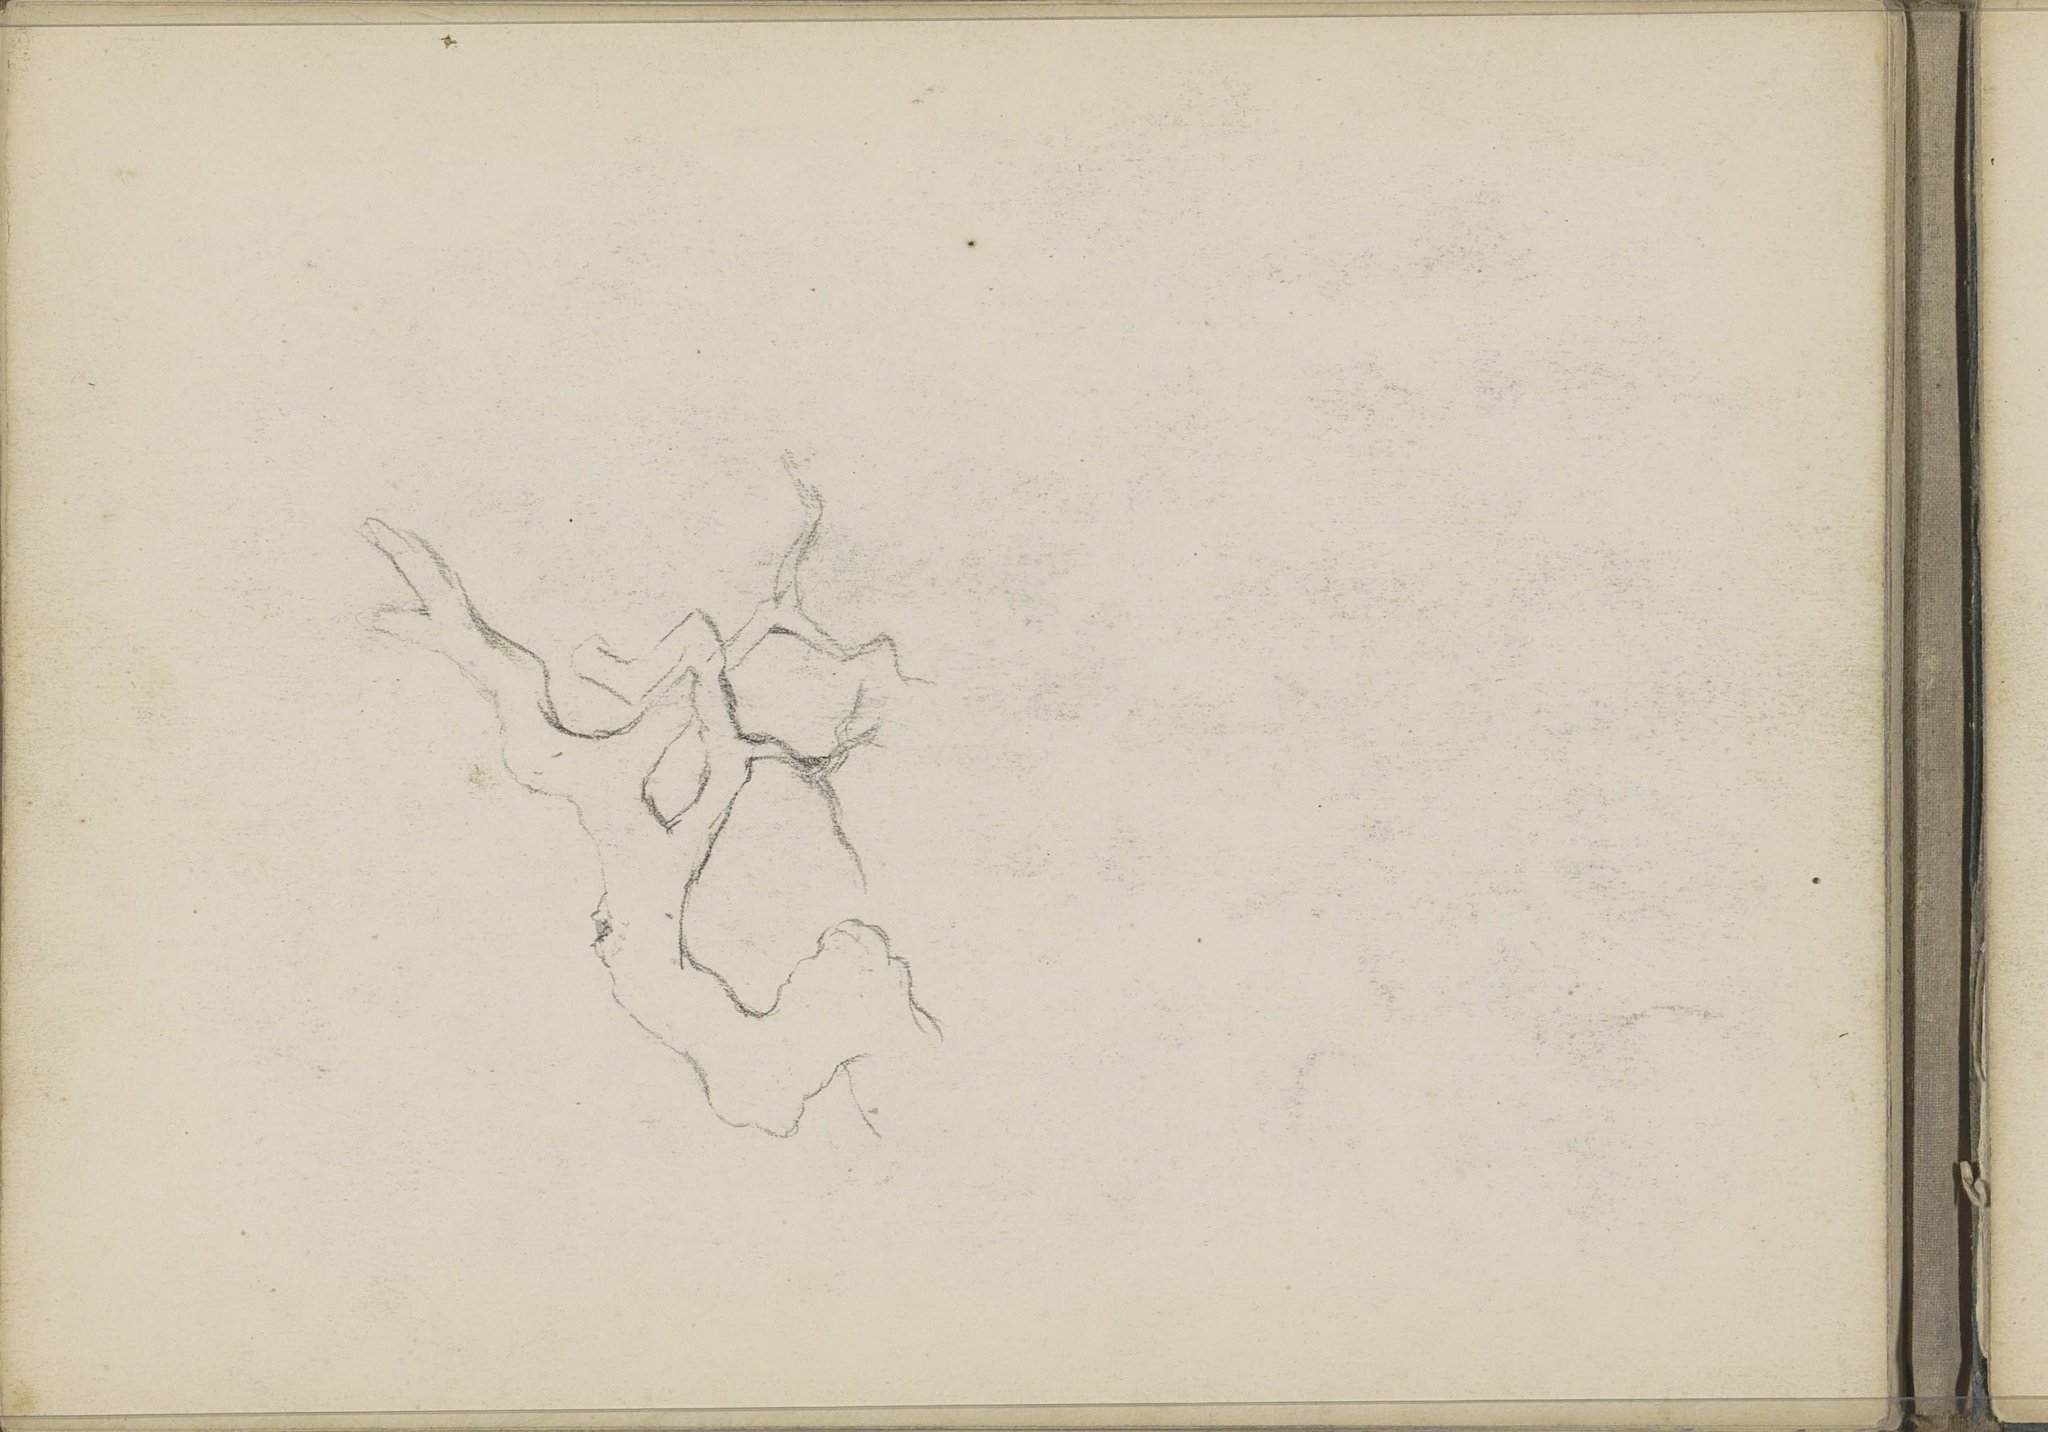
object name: sketchbook leaf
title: Boomtakken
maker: willem cornelis rip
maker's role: draughtsman, painter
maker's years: 1856-1922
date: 1874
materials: chalk, paper, pencil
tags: trees (+ branch, stick)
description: Blad 22 verso uit een schetsboek met 27 losse bladen.